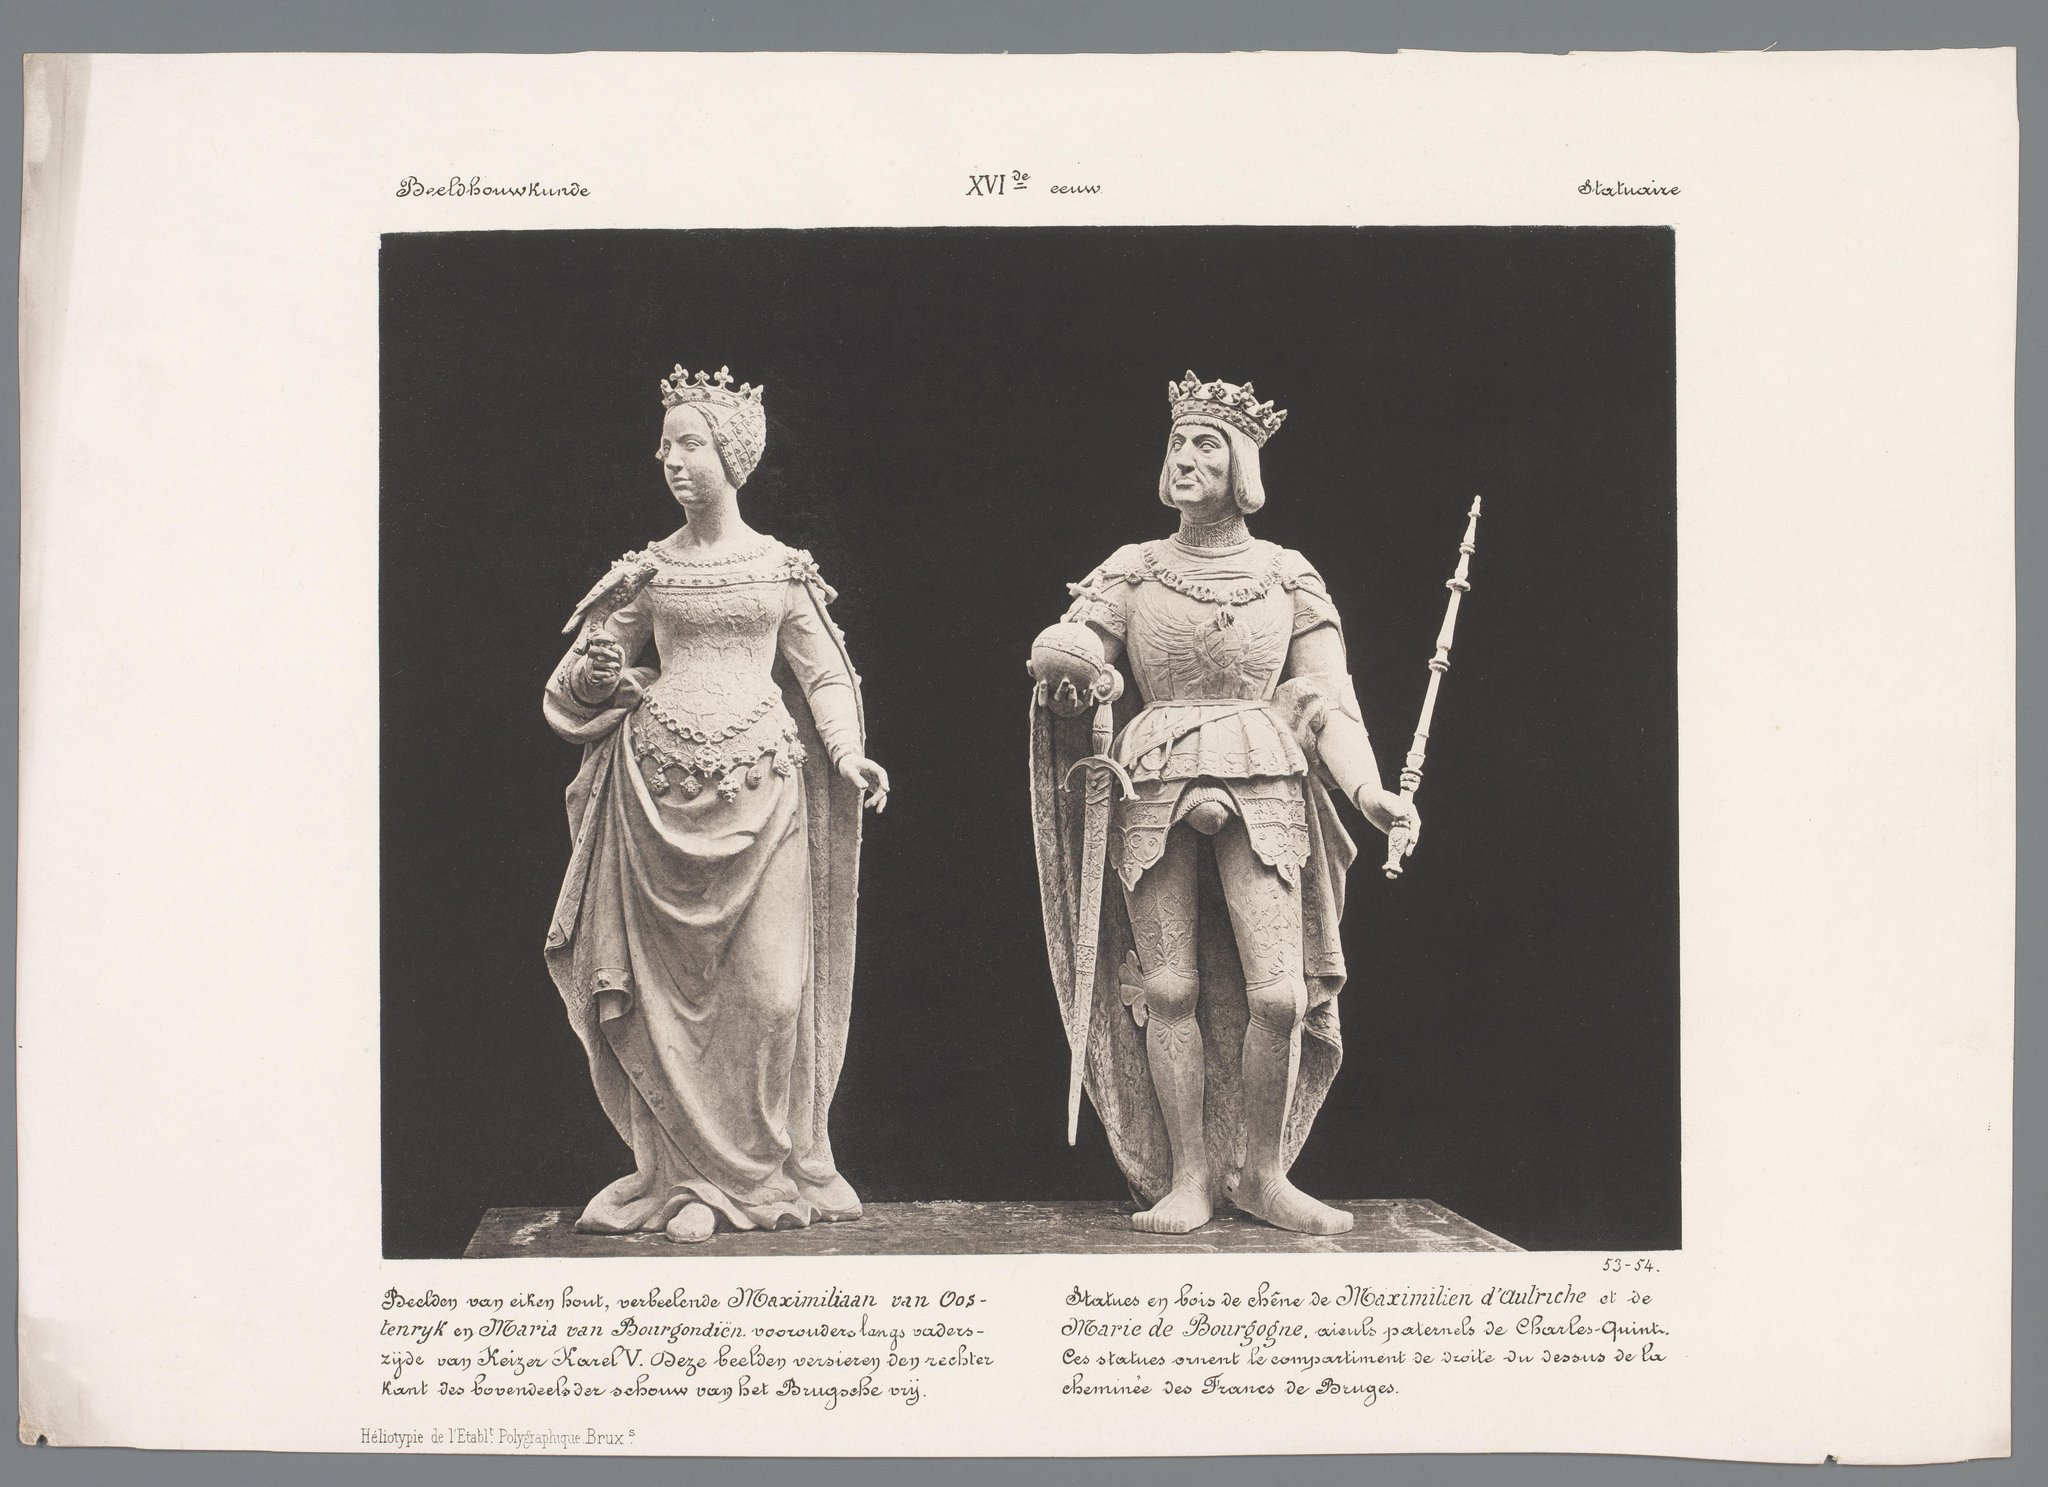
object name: reproduction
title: Reproductie van twee eikenhouten standbeelden van Maria van Bourgondië en keizer Maximiliaan I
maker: alexandre de blochouse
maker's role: fotograaf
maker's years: 1821-1901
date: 1880-1900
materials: paper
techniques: photoaquatint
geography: brussels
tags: brussels, bruges, maria (hertogin van bourgondië), maximilian i (holy roman emperor), ruler, sovereign, sculpture